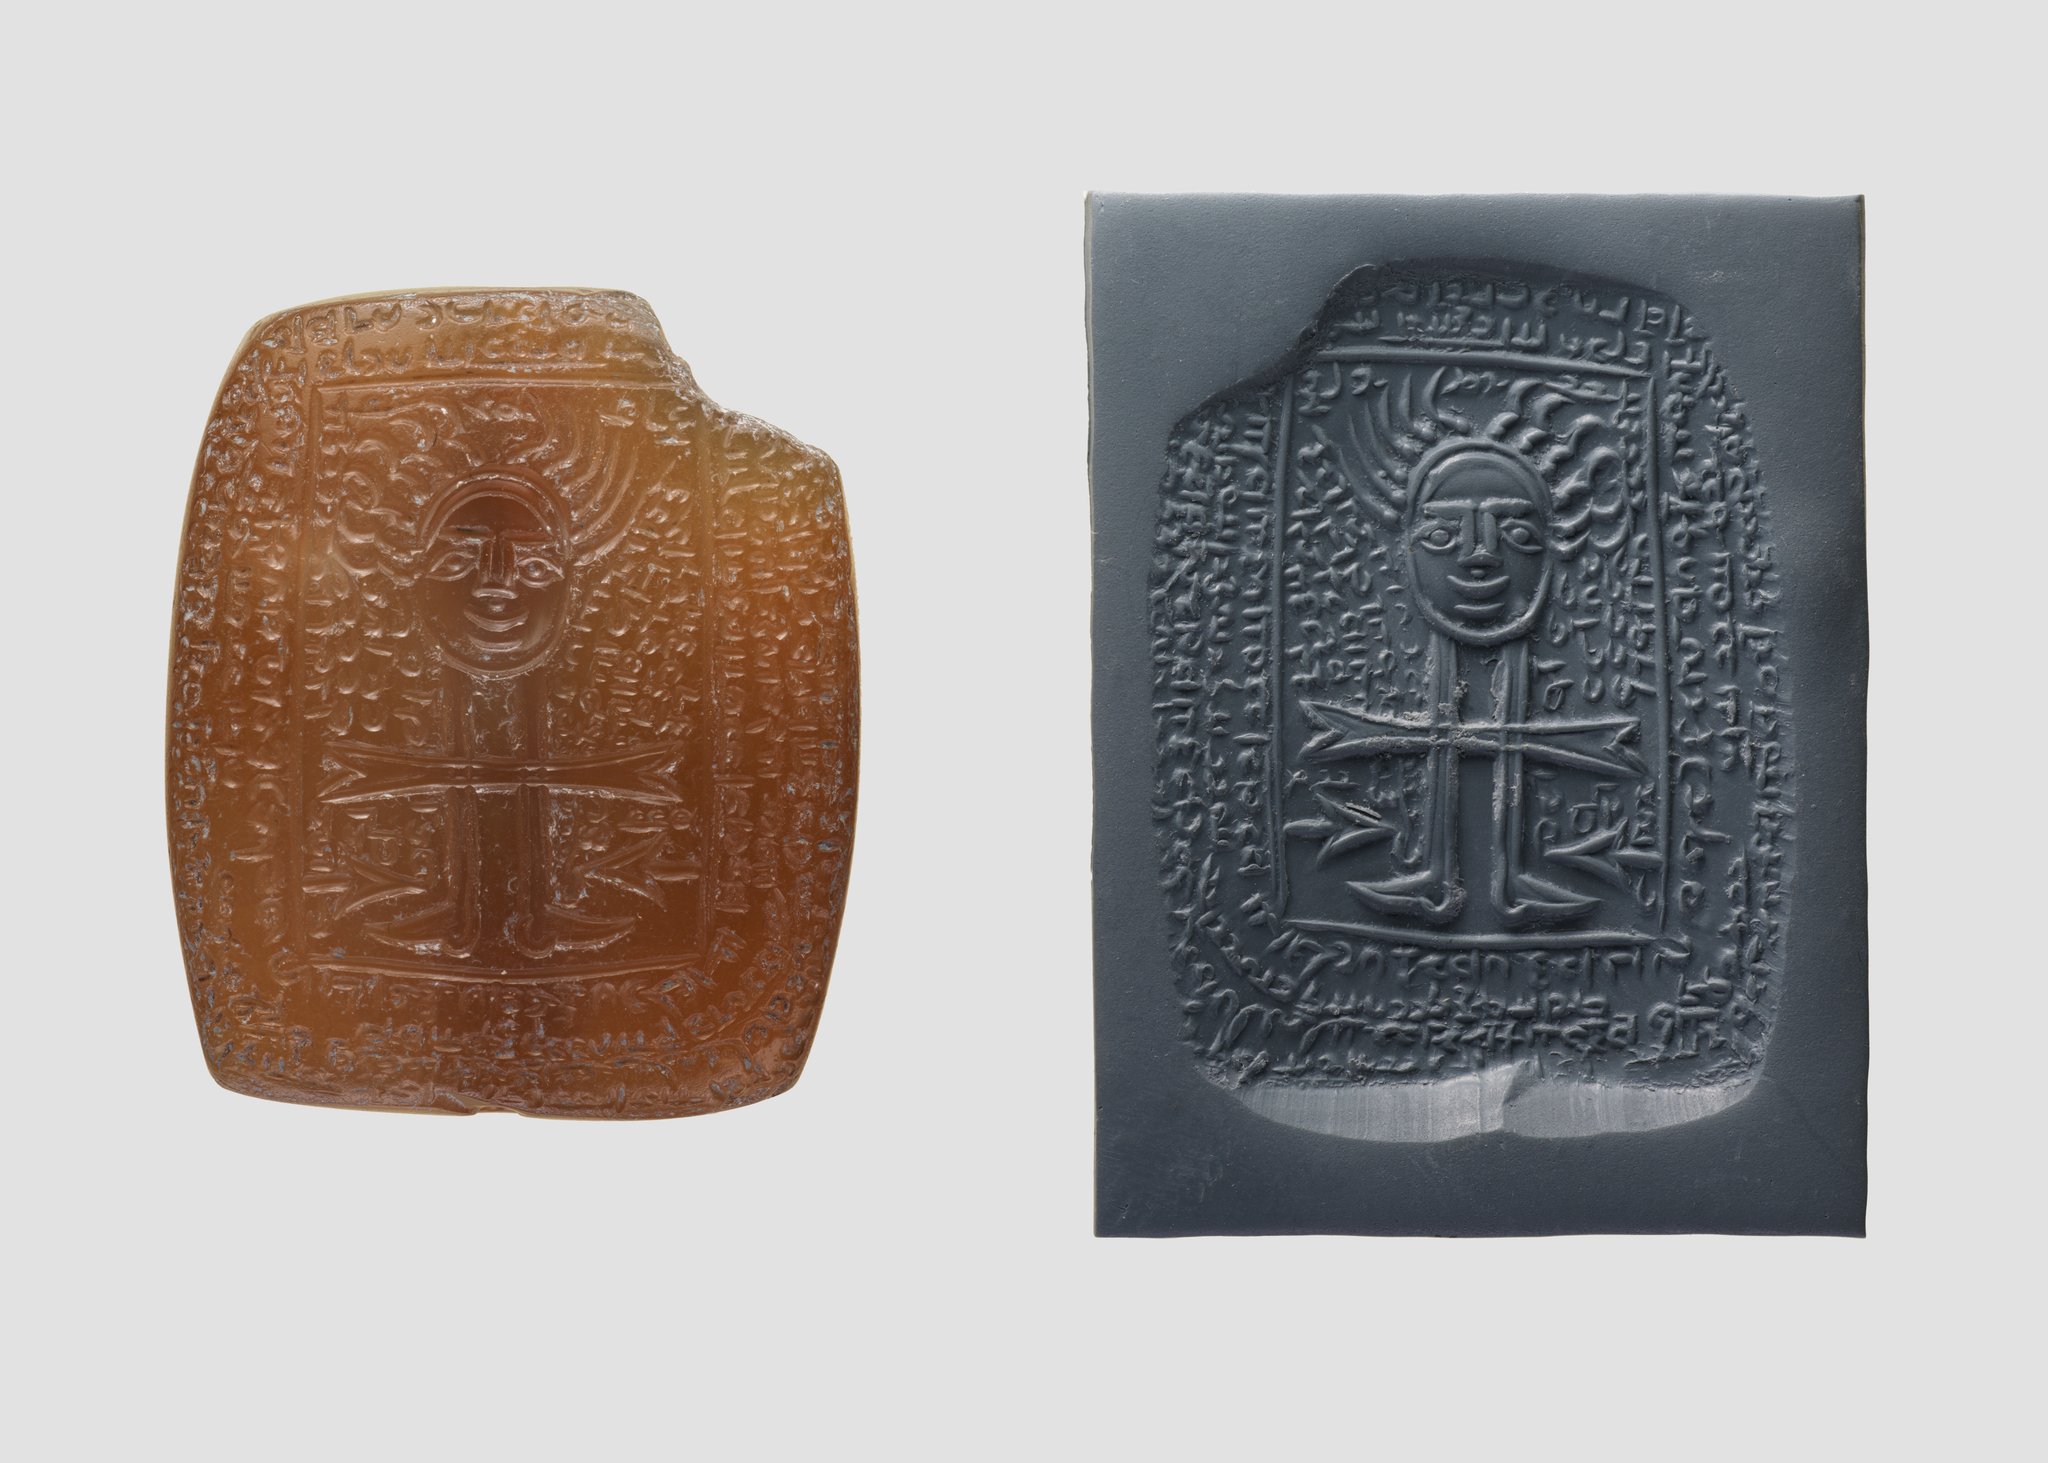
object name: necklace, bead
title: Amulet inscribed in Middle Persian script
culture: sasanian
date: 301-400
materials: stone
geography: iran